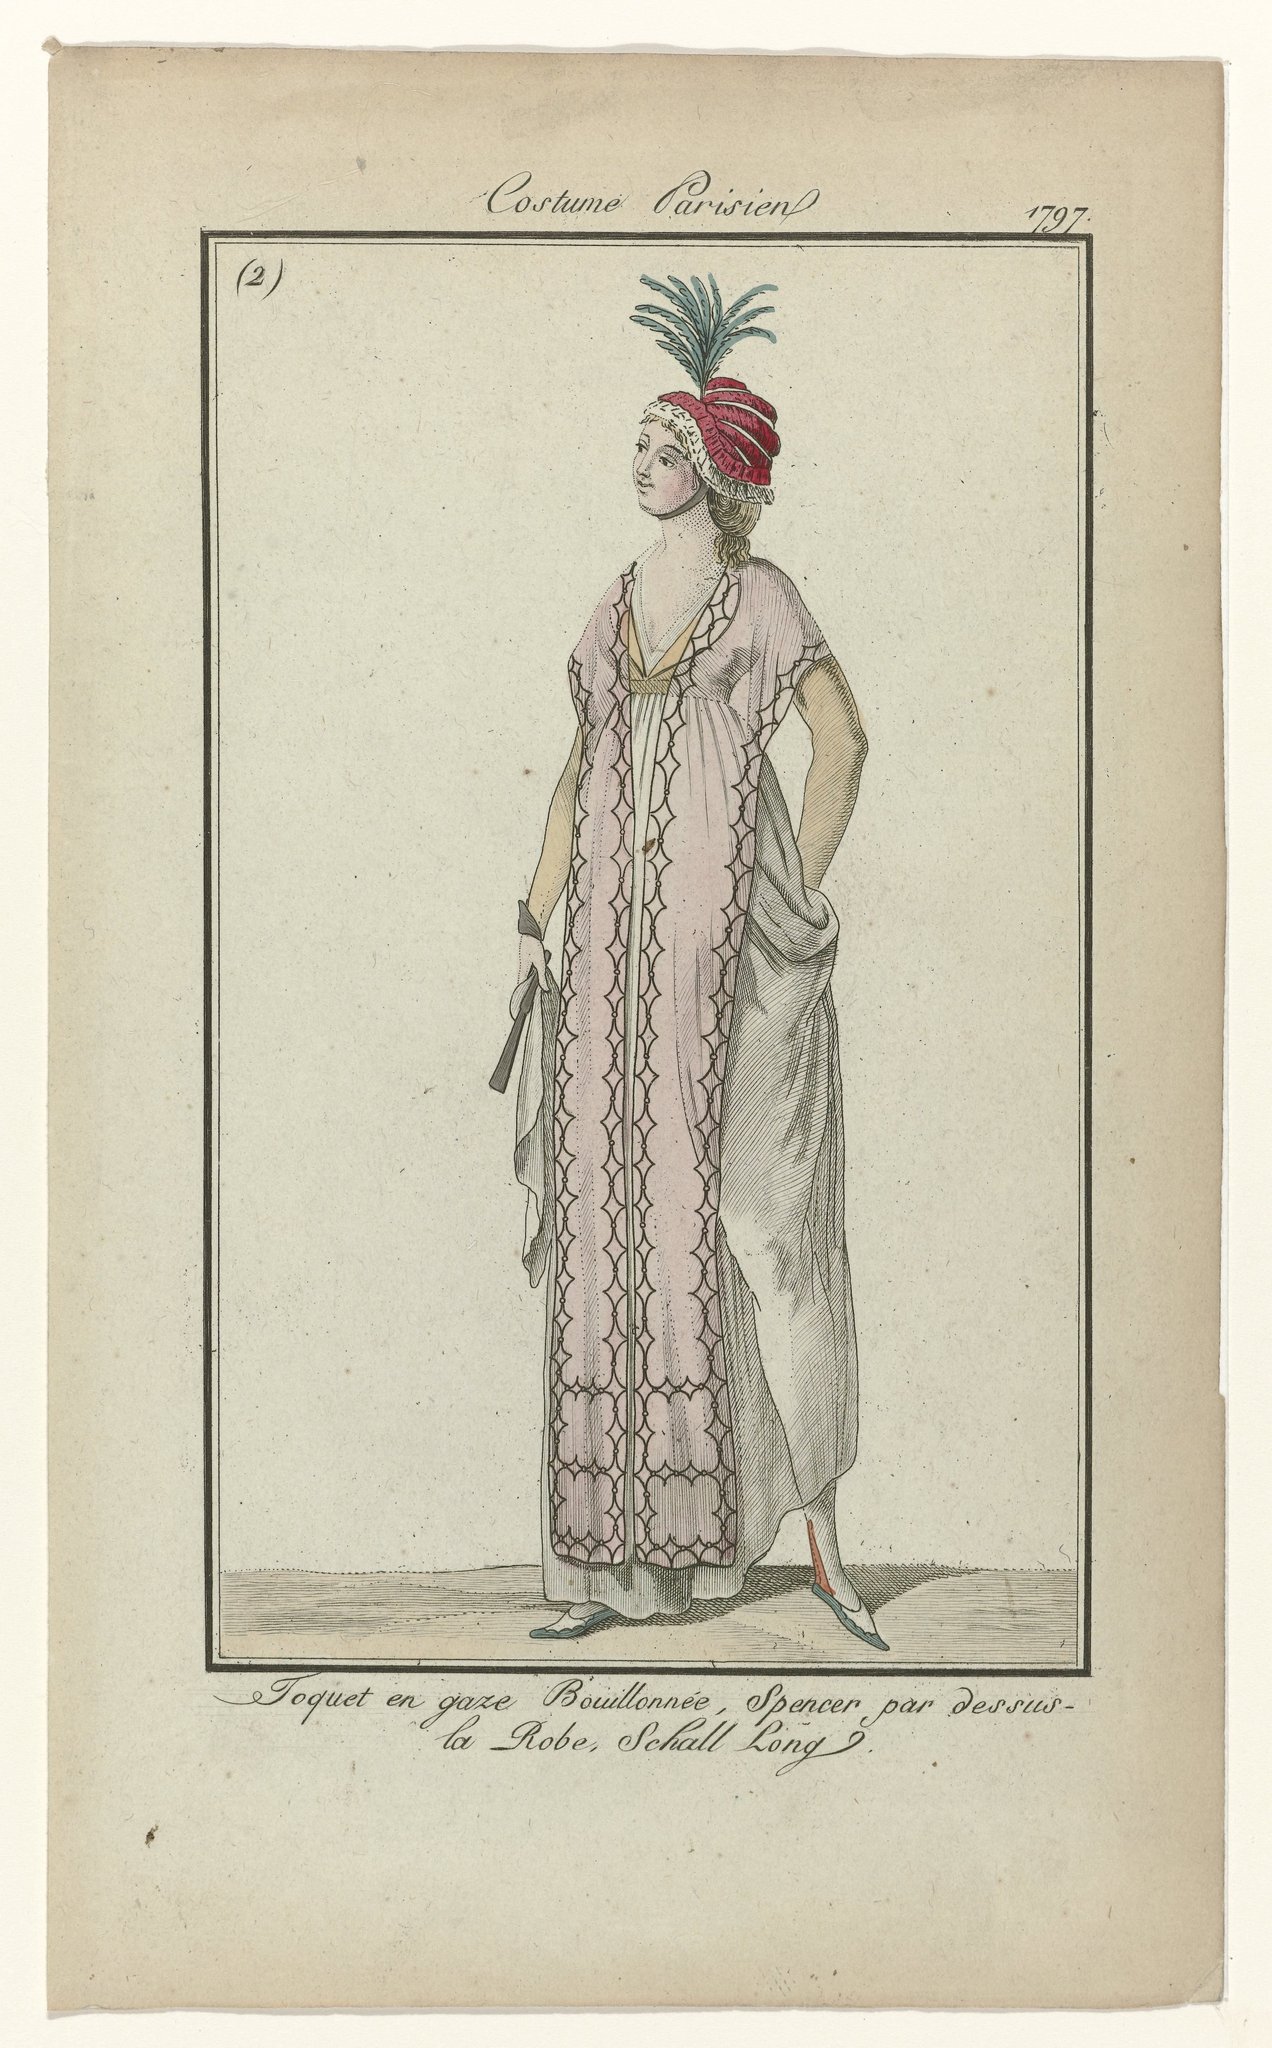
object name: fashion print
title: Journal des Dames, Costume Parisien, juillet 1797 (2) : Toquet en gaze Bouillonné (...)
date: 1797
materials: paper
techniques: engraving, hand coloring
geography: paris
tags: handkerchief (+ women's clothes), head-gear: toque (+ women's clothes), clothing for the upper part of the body (shawl) (+ women's clothes), clothing for the upper part of the body (spencer) (+ women's clothes), fashion plates, shoes, sandals (+ women's clothes), dress, gown (+ women's clothes), stockings, socks (+ women's clothes), fan (+ women's clothes)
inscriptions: title: ‘Costume Parisien.’, caption: ‘Toquet en gaze Bouillonnée, Spencer par dessus la Robe, Schall Long.’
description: 'Toquet' van geplooide tule. Spencer op een japon. Om de hals een doorzichtige lange sjaal versierd met een geometrisch patroon. Verdere accessoires: waaier, zakdoek, platte schoenen met puntige neuzen met een contrasterende versiering. De prent maakt deel uit van het modetijdschrift Journal des Dames et des Modes, uitgegeven door Sellèque, Parijs, 1797-1839. De prent werd eerder uitgegeven in het 'Journal des Modes et Nouveautés' als nummer 2, met het onderschrift 'Costumes'.